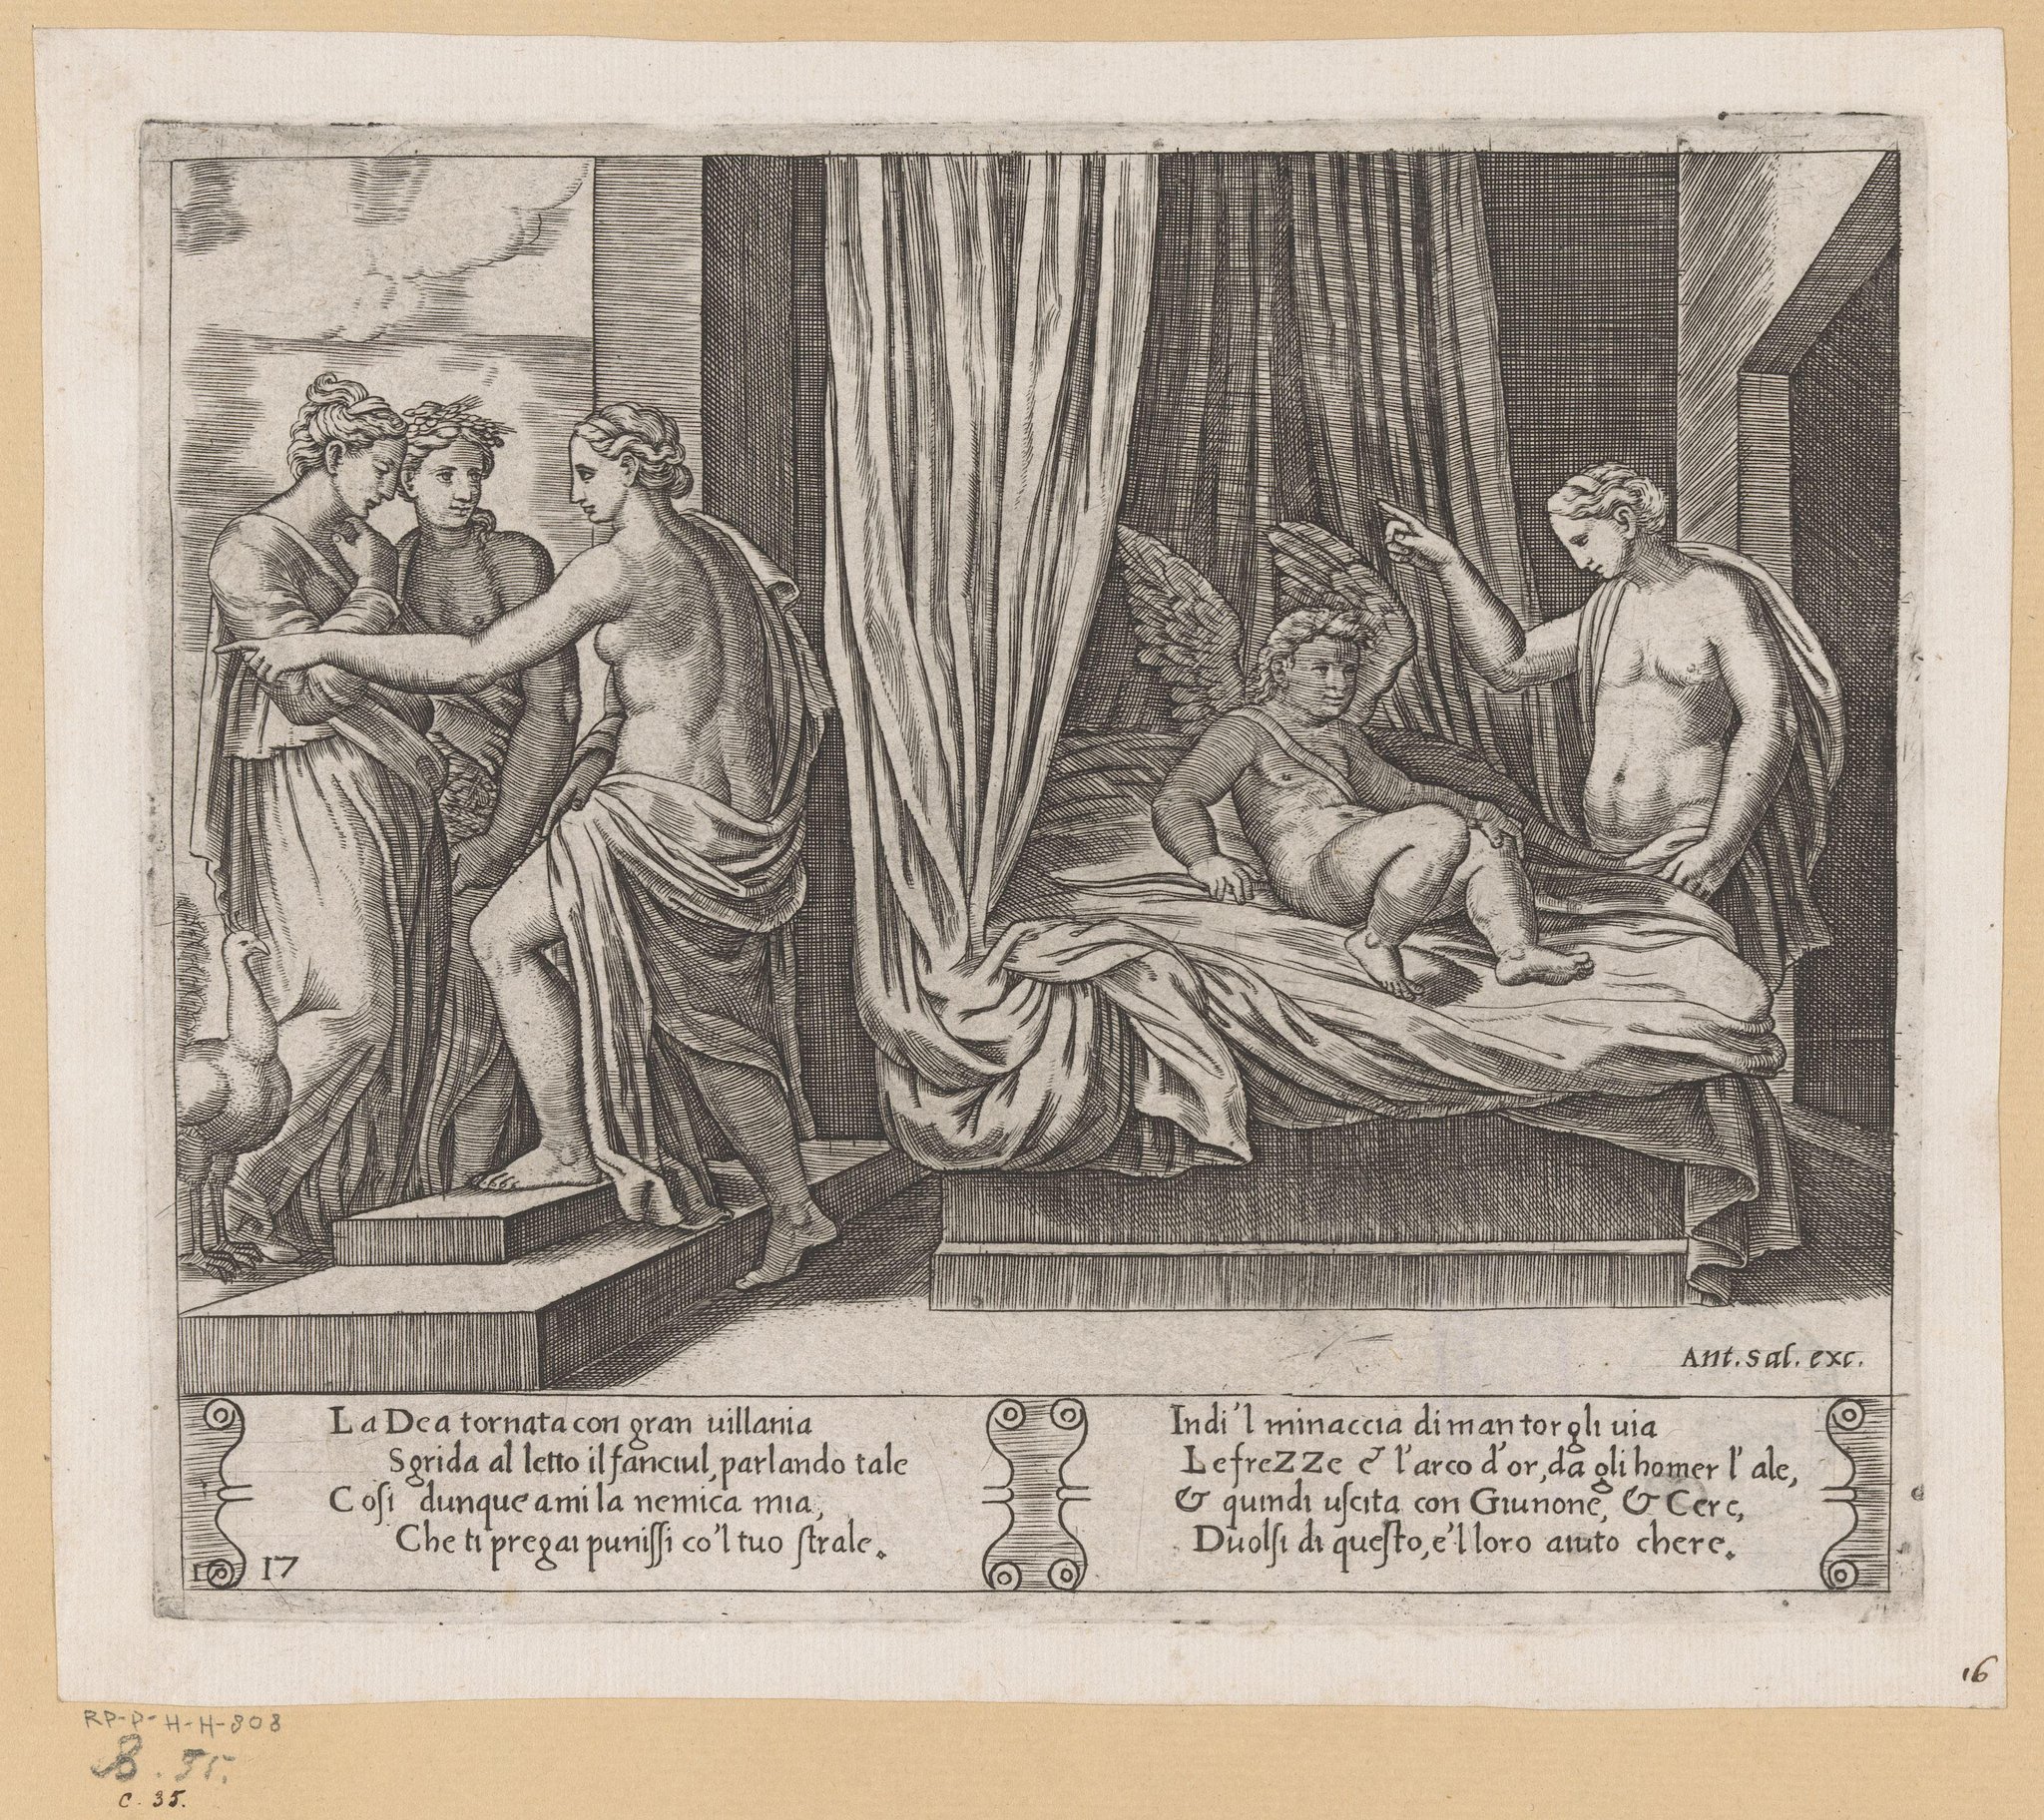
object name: print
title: Verhaal van Amor en Psyche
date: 1530-1560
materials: paper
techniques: engraving, intaglio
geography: rome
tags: psyche with juno, psyche with ceres, venus punishing cupid, other scenes from the story of cupid and psyche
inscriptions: collector's mark: ‘Hinloopen’, number: ‘16’, collector's mark: Lugt 10, collector's mark: Lugt 11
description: Venus straft haar zoon Amor vanwege zijn liefde voor de koningsdochter Psyche. Links staat Psyche samen met de godinnen Juno en Ceres. Italiaanse tekst in twee cartouches in ondermarge. Tweemaal genummerd linksonder: 17.